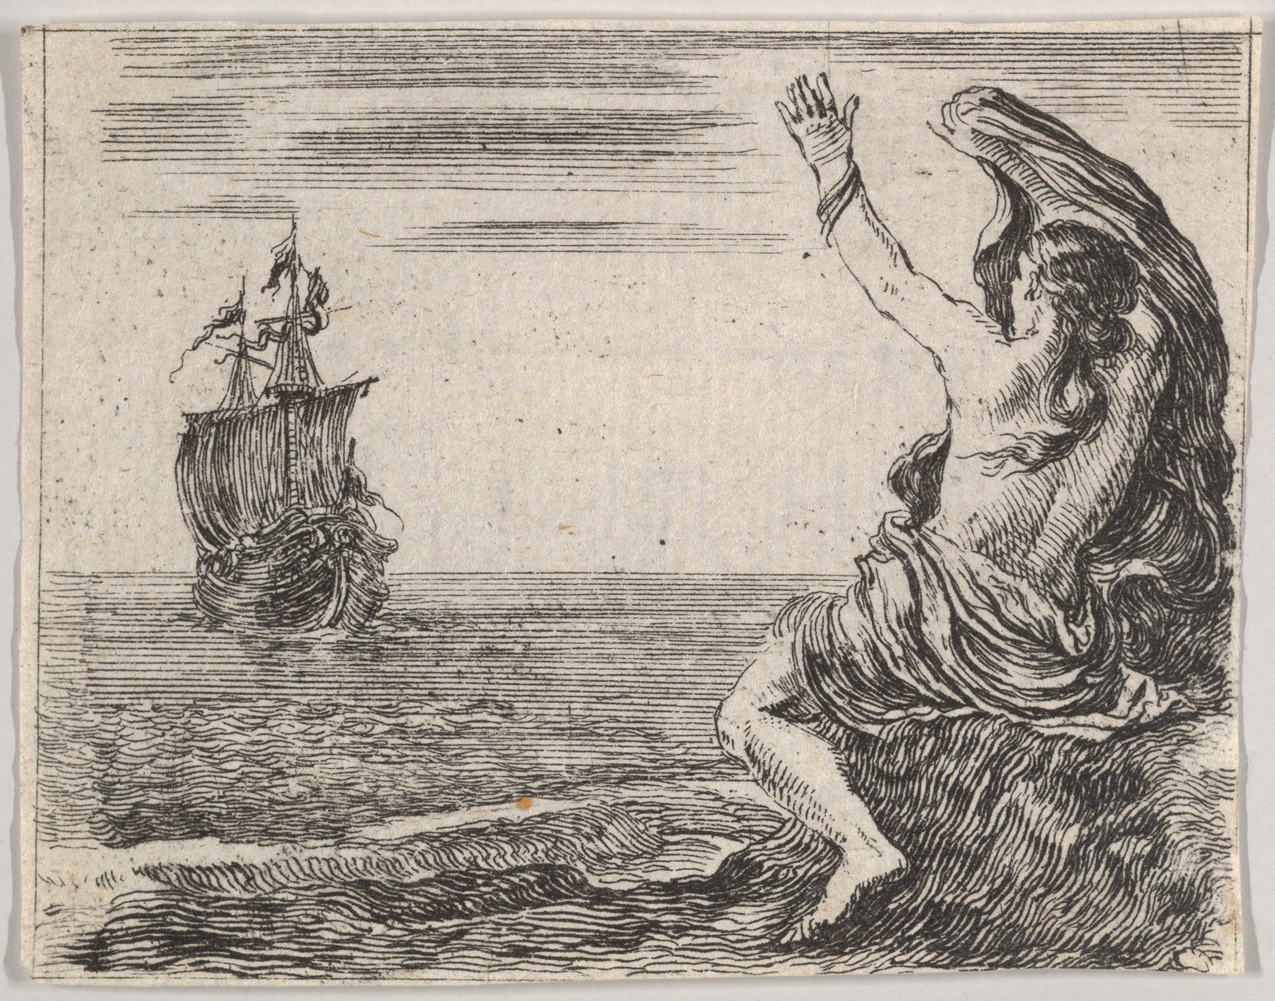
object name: print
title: Theseus and Ariadne, from "Game of Mythology" (Jeu de la Mythologie)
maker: stefano della bella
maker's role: artist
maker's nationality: italian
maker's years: 1610-1664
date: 1644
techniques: etching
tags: ariadne,ships